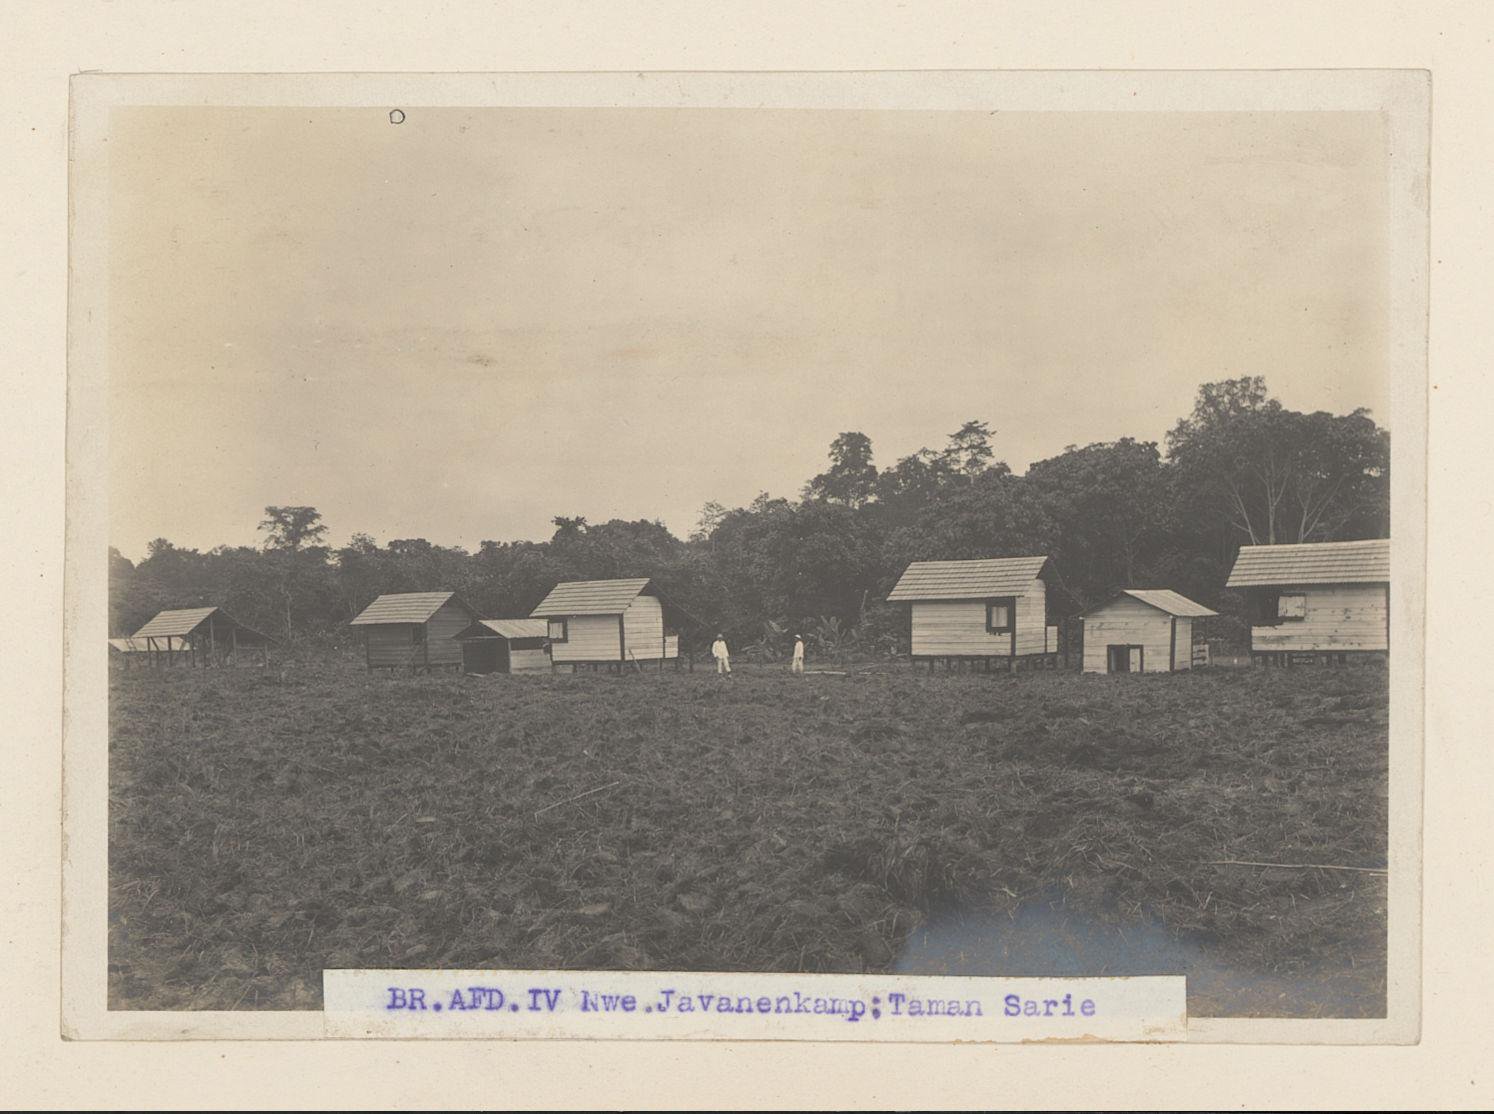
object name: photograph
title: Br. Afd. IV Nwe. Javanenkamp; Taman Sarie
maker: Anonymous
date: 1913-1924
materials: photographic support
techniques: gelatin silver print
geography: east sumatra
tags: plantation, (non-fruit) products of plants or trees: rubber, working class, labourers, cottage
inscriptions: inscription: ‘Br. Afd. IV Nwe. Javanenkamp; Taman Sarie’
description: Huizen voor Javaanse arbeiders bij afdeling IV van de plantage Brussel. Bij de huizen staan twee Europese mannen in witte pakken. Met etiket onder de foto. Onderdeel van het fotoalbum over de plantages Brussel en Pernantian van de Sumatra Caoutchouc Maatschappij op de Oostkust van Sumatra in de jaren 1910-1935.